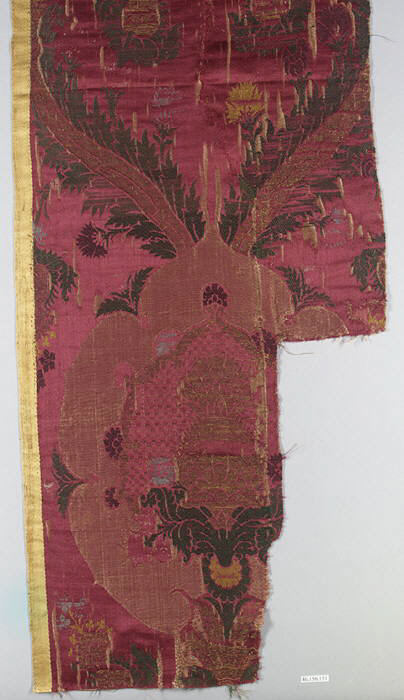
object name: piece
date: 1467-1500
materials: metal thread, silk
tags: flowers,leaves